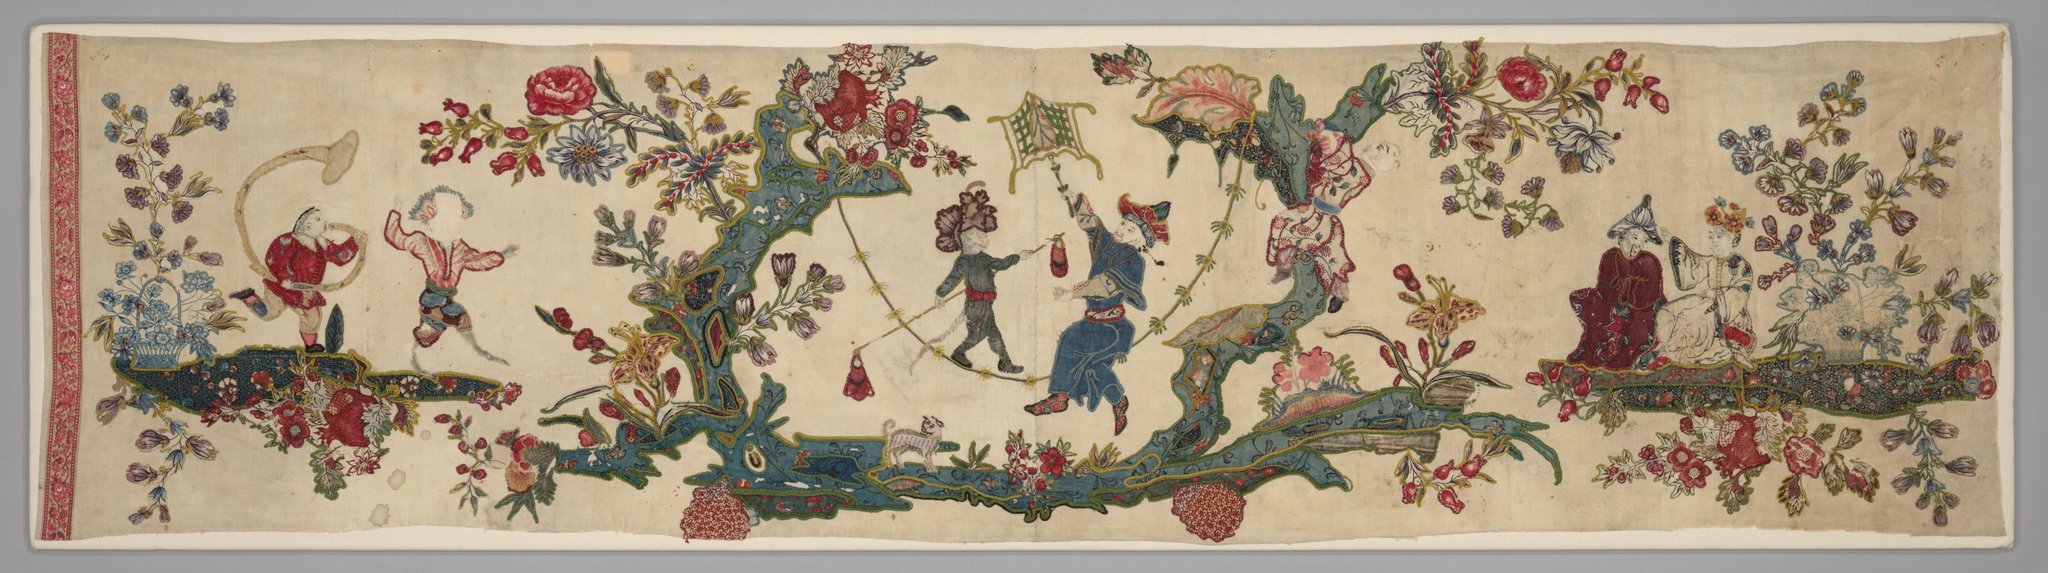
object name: lambrequin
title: Lambrekijn of fragment met chinoiserieën in sitsen applicatie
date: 1700-1750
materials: textile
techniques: printing, weave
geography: india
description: Lambrekijn of fragment met een afbeelding van een blauwgroene grond waarop twee bomen waartussen een touw. Op het touw zit een Chinees en danst een aap. Links van de boom loopt een hoornspelende Chinees en een dansende aap. Rechts zitten twee Chinese toeschouwers. De lambrekijn of het fragment hoort bij drie andere fragmenten (BK-16441-B t/m BK-16441-E) en een sprei (BK-16441-A). Oosterse textiel.